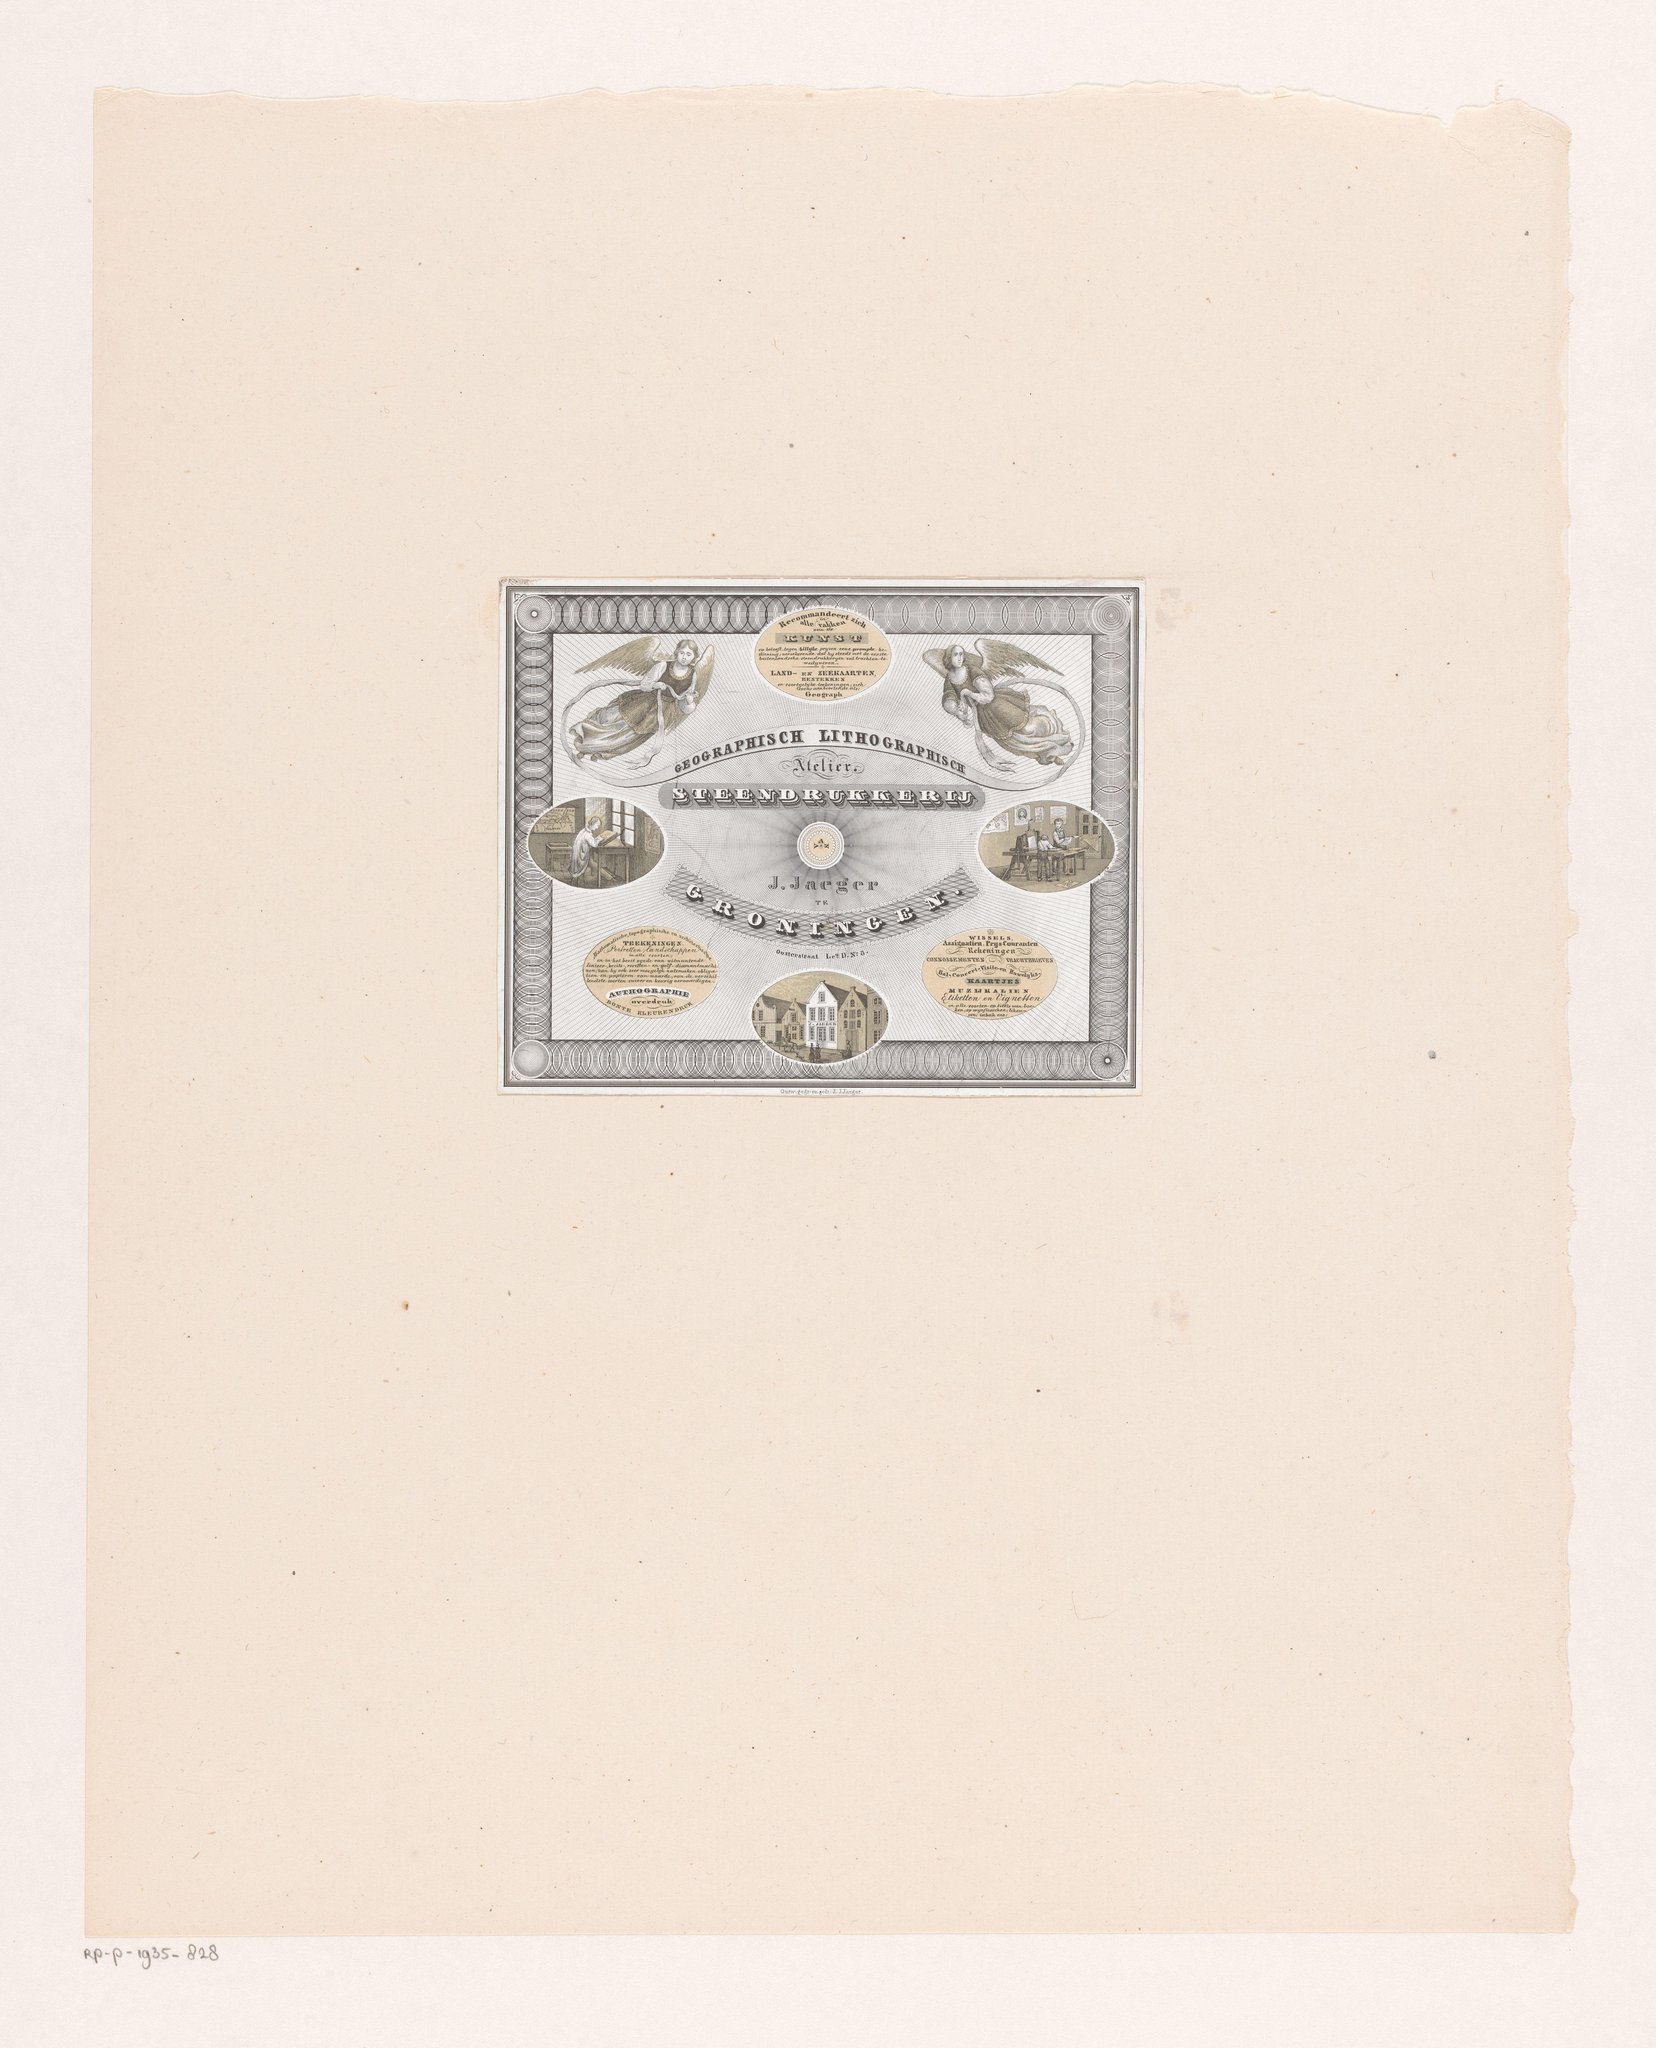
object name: porcelain card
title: Visitekaartje van de Lithografische Drukkerij van J. Jaeger te Groningen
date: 1843-1856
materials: paper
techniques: tone lithography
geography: groningen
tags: lithographer, printing press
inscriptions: collector's mark: Lugt 2760, collector's mark: Lugt 2228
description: Links- en rechtsboven twee engelen. In de vignetten een lithograaf tekent op steen, twee figuren bij een drukpers en het pand van de drukkerij aan de Oosterstraat.